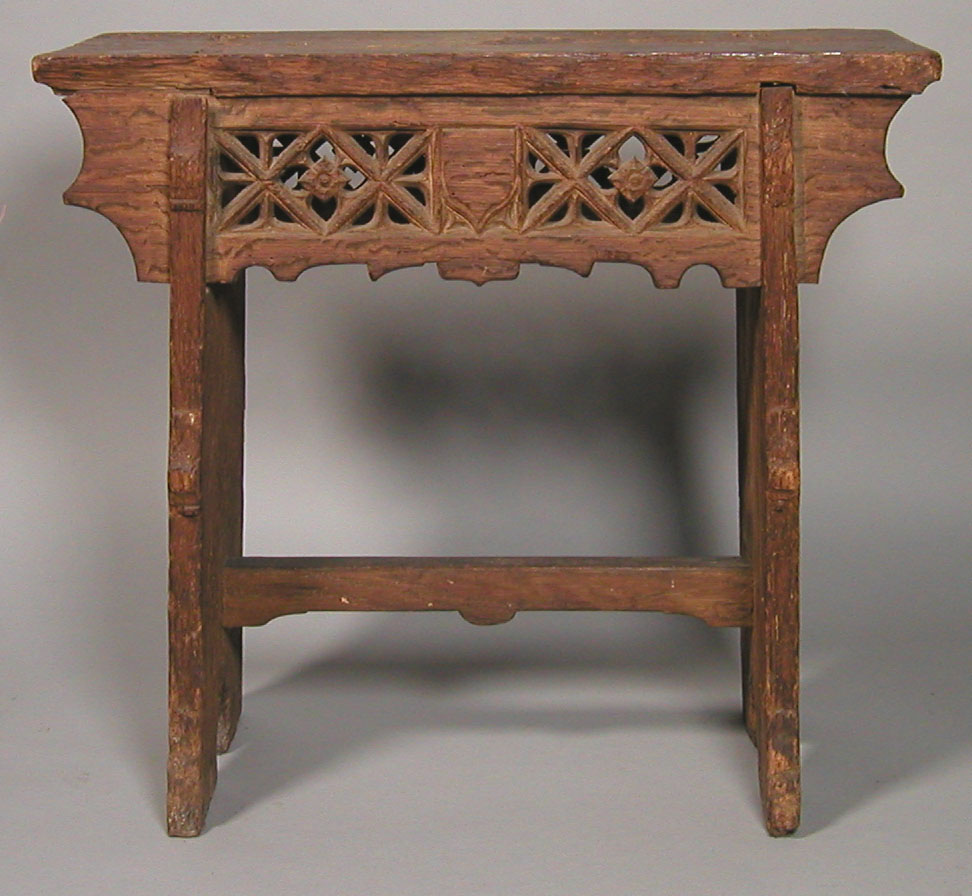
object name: stool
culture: french or south netherlandish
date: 1401-1500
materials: wood